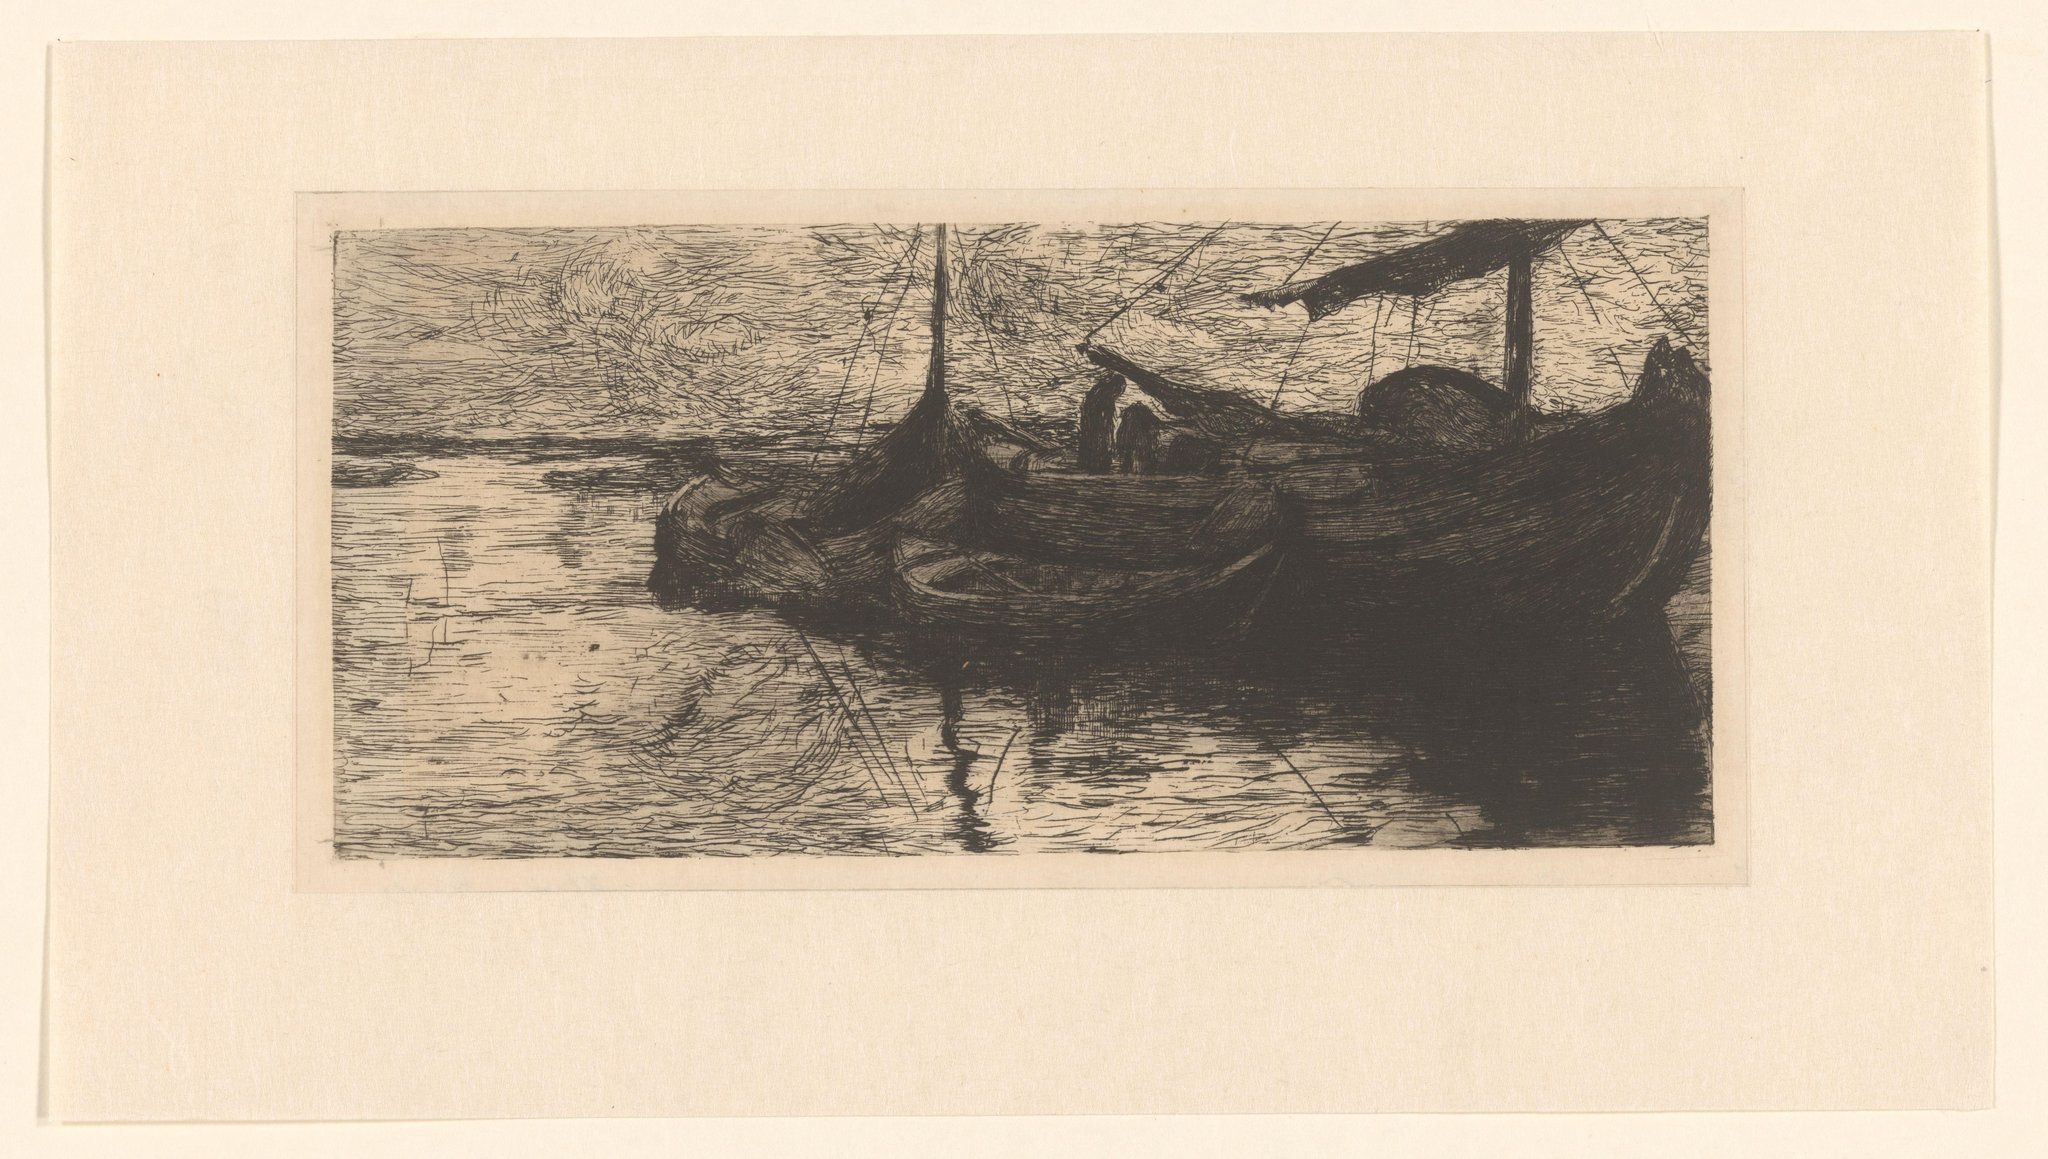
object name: print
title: Schepen in een kanaal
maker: floris verster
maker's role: draughtsman, painter, print maker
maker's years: 1861-1927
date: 1889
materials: paper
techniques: drypoint, etching, intaglio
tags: sailing-ship, sailing-boat, canal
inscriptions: collector's mark: Lugt 2228